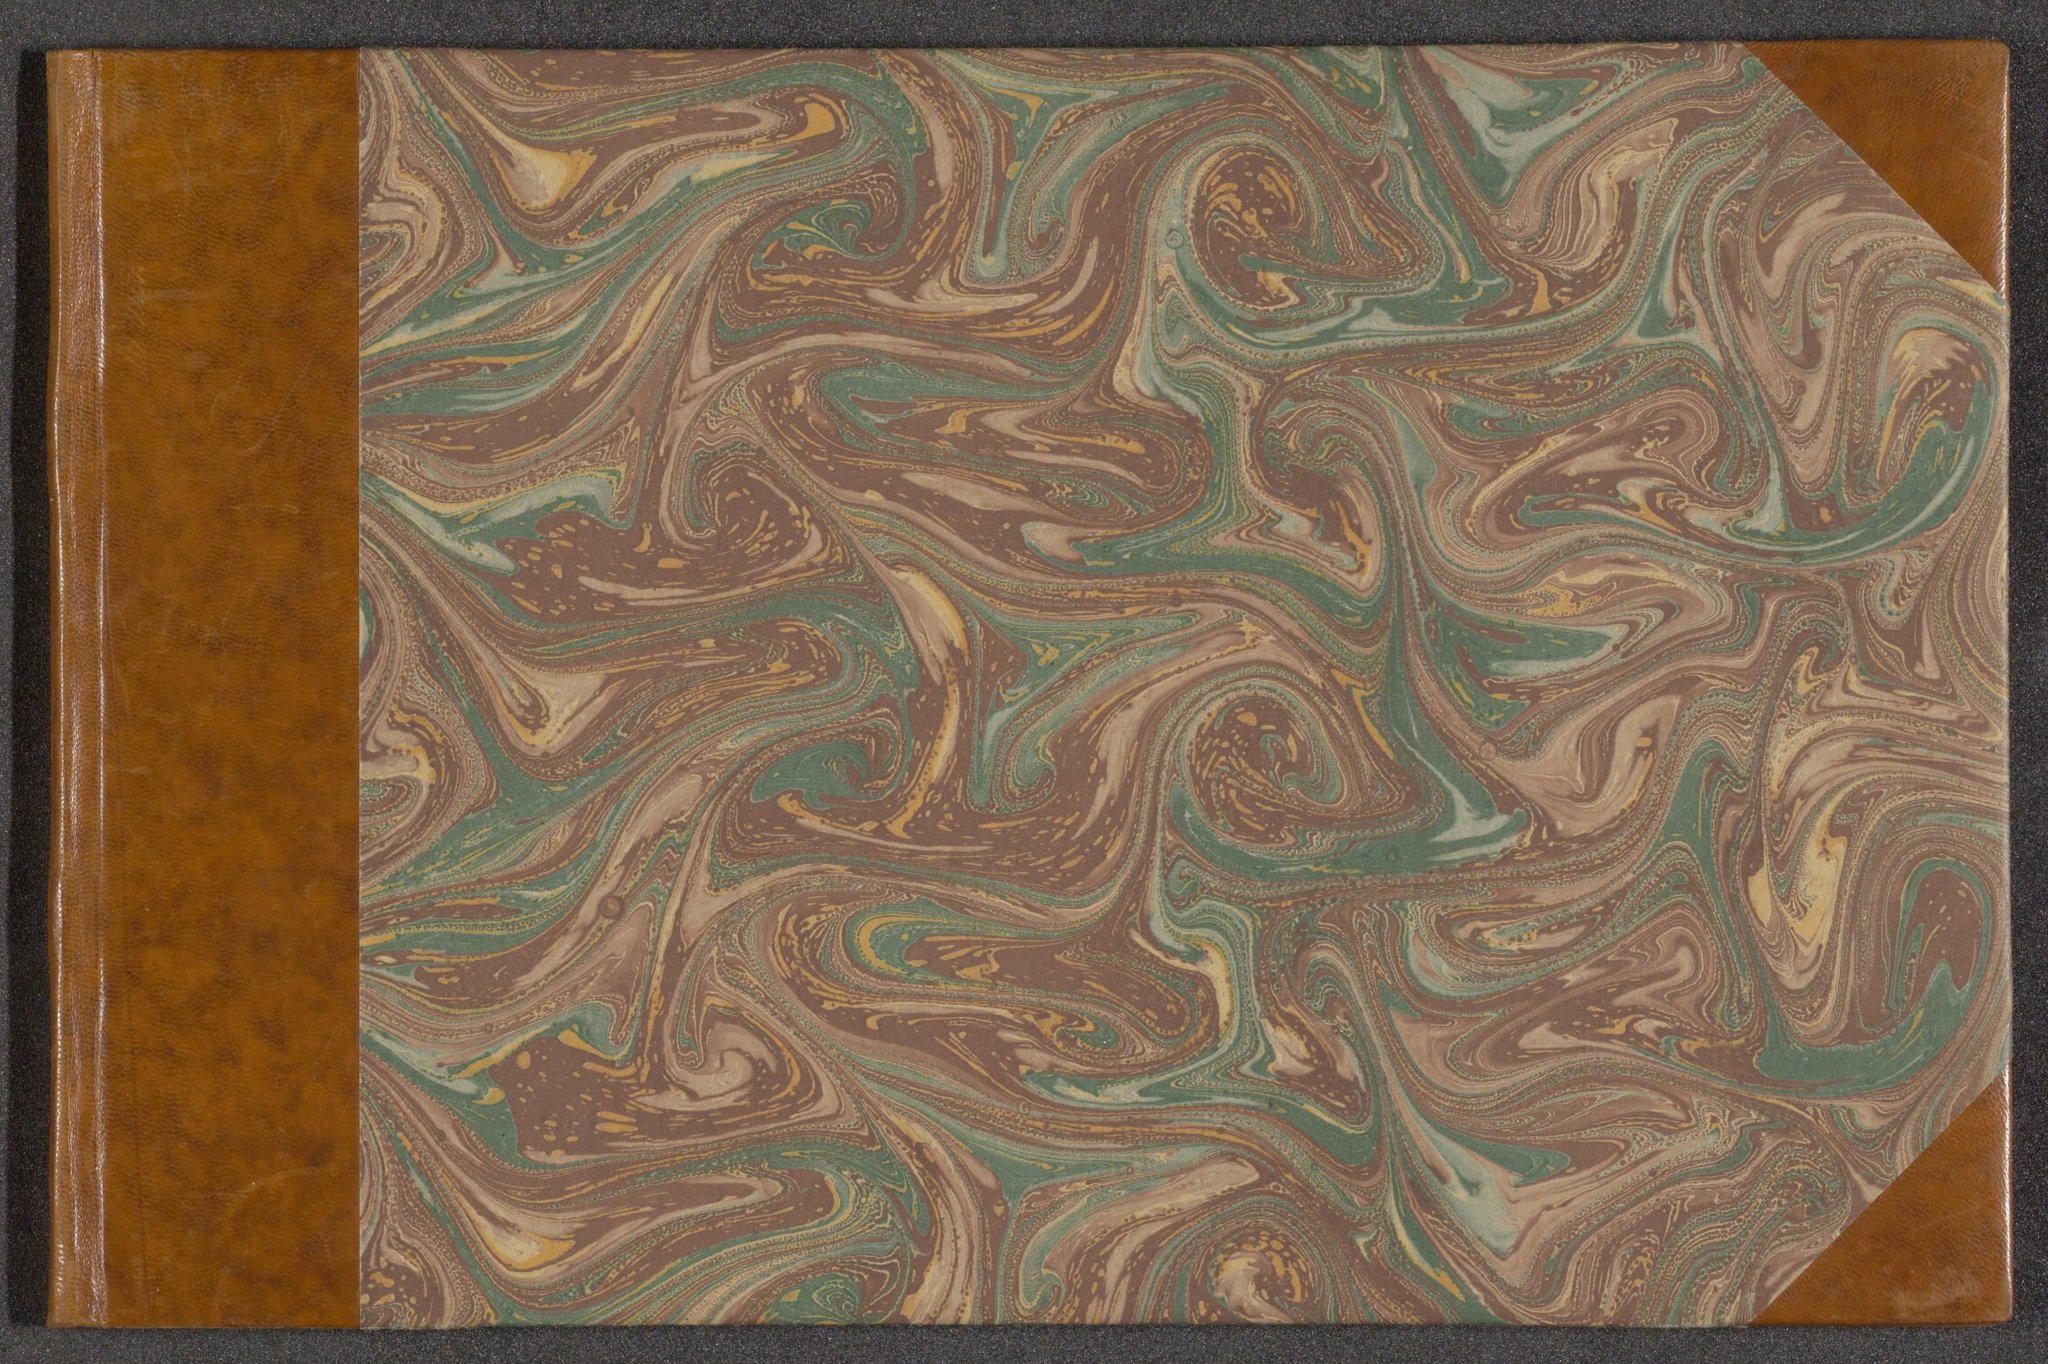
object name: prentrecueil, prentenalbum, prentalbum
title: Album met voorstellingen van bloemen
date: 1630-1718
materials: leather, paper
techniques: bookbinding, etching, marbling, marbled paper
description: Album met een serie bloemen bestaande uit 12 prenten, in een halfleren band met op de boekplatten fantasiemarmerpapier. Voor- en achterin twee schutbladen.